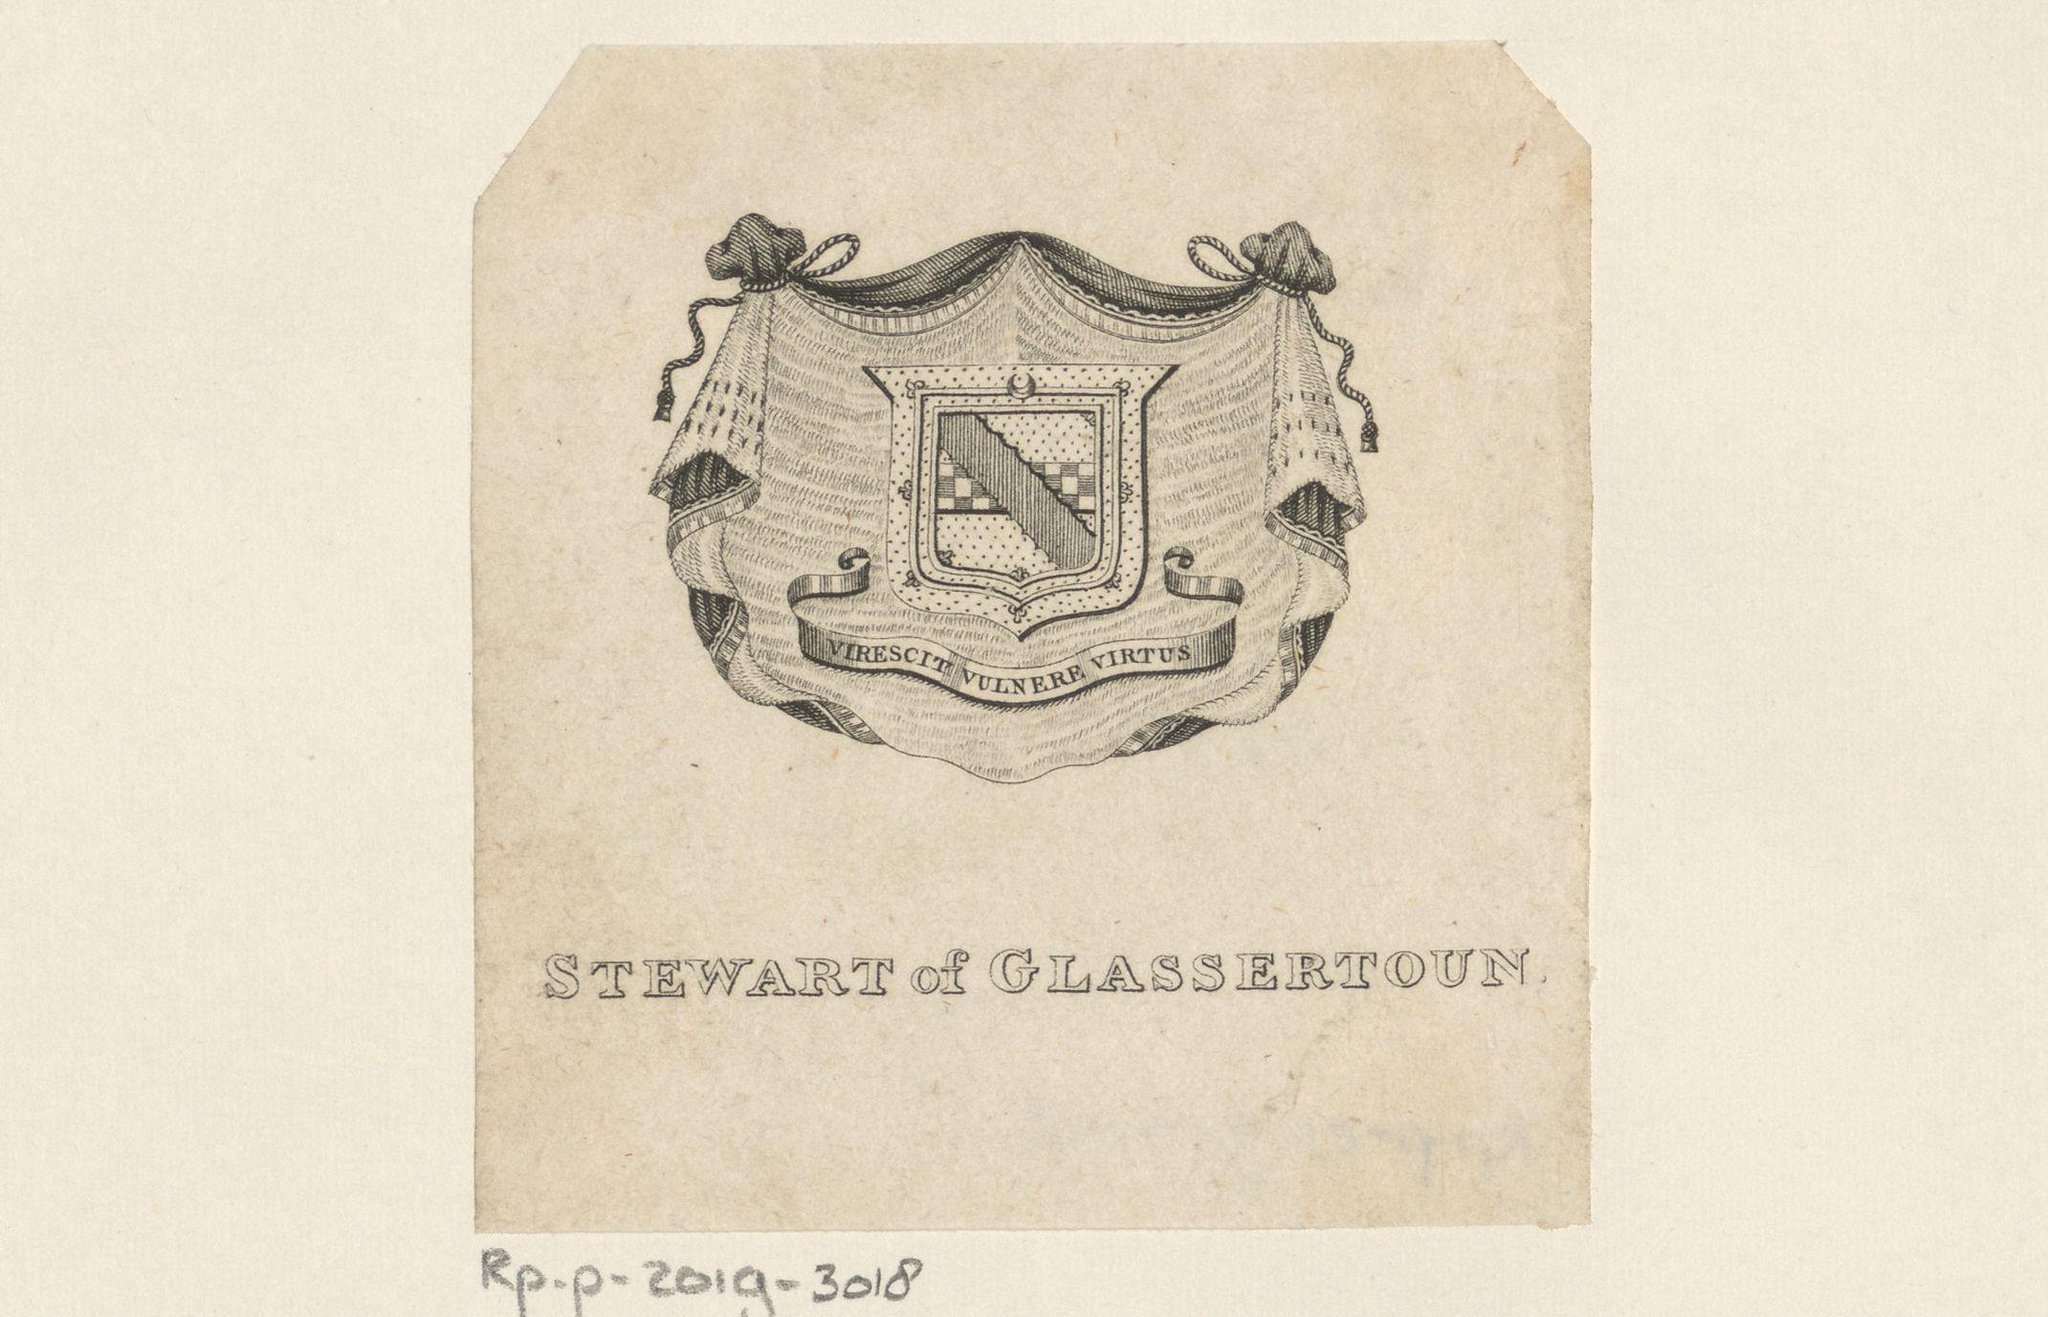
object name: bookplate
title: Virescit vulnere virtus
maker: Anonymous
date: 1800-1899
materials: paper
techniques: etching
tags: armorial bearing, heraldry